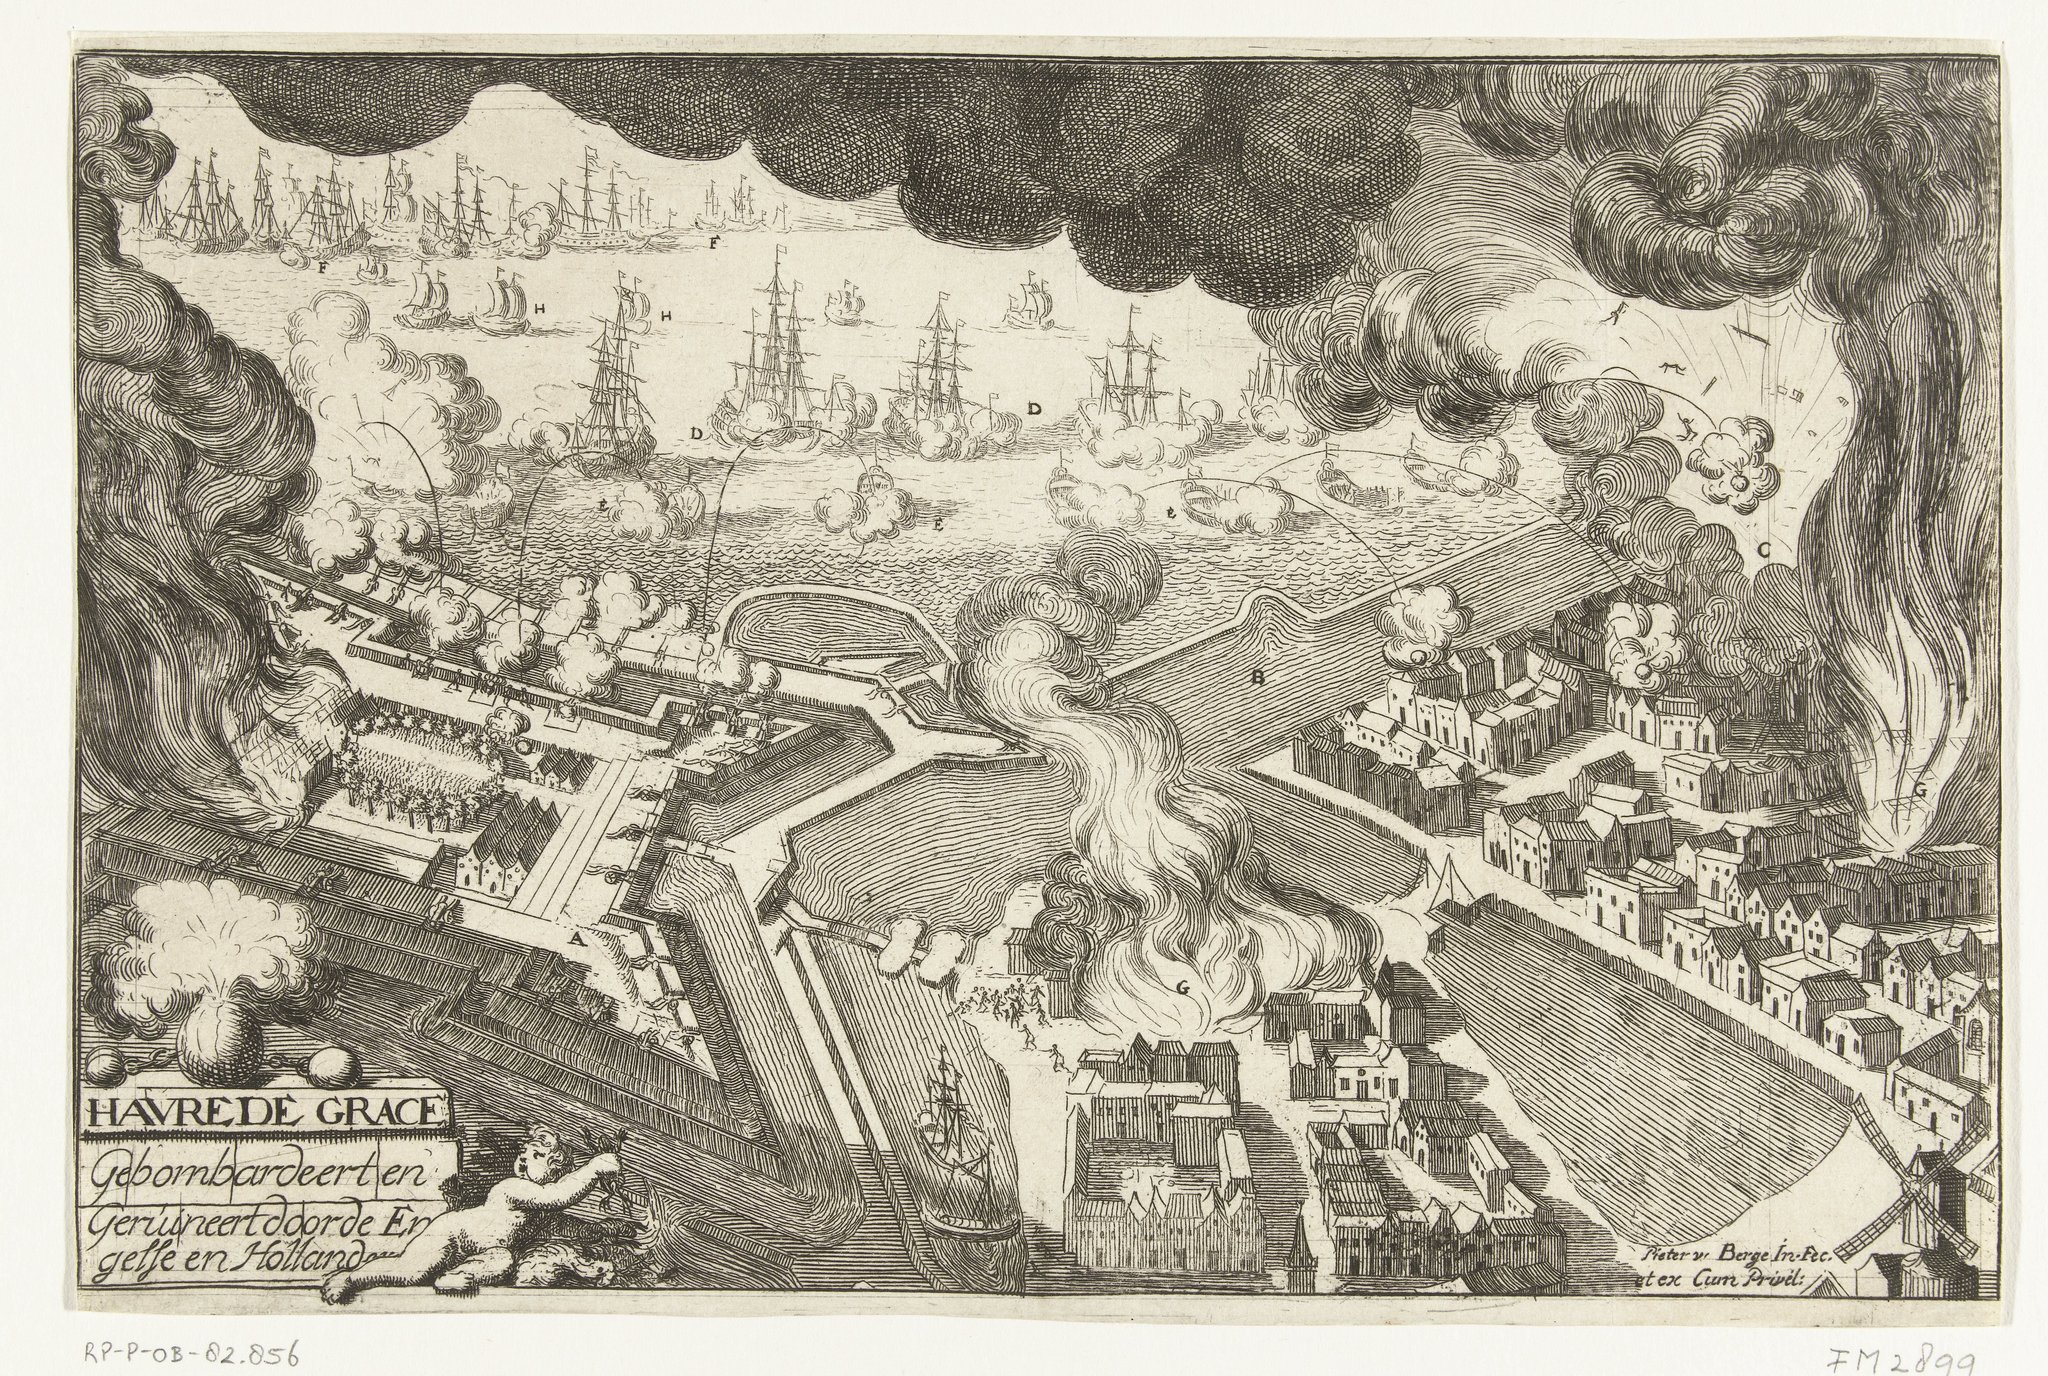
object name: print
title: Bombardement van Le Havre door de Geallieerden, 1694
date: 1694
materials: paper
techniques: etching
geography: northern netherlands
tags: bombardment, le havre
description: Bombardement van de Franse havenplaats Le Havre door de gecombineerde Engelse en Hollandse vloot, 28 (of 25?) juli 1694. De stad staat in brand. Details in de voorstelling gemerkt met letters maar een legenda ontbreekt.